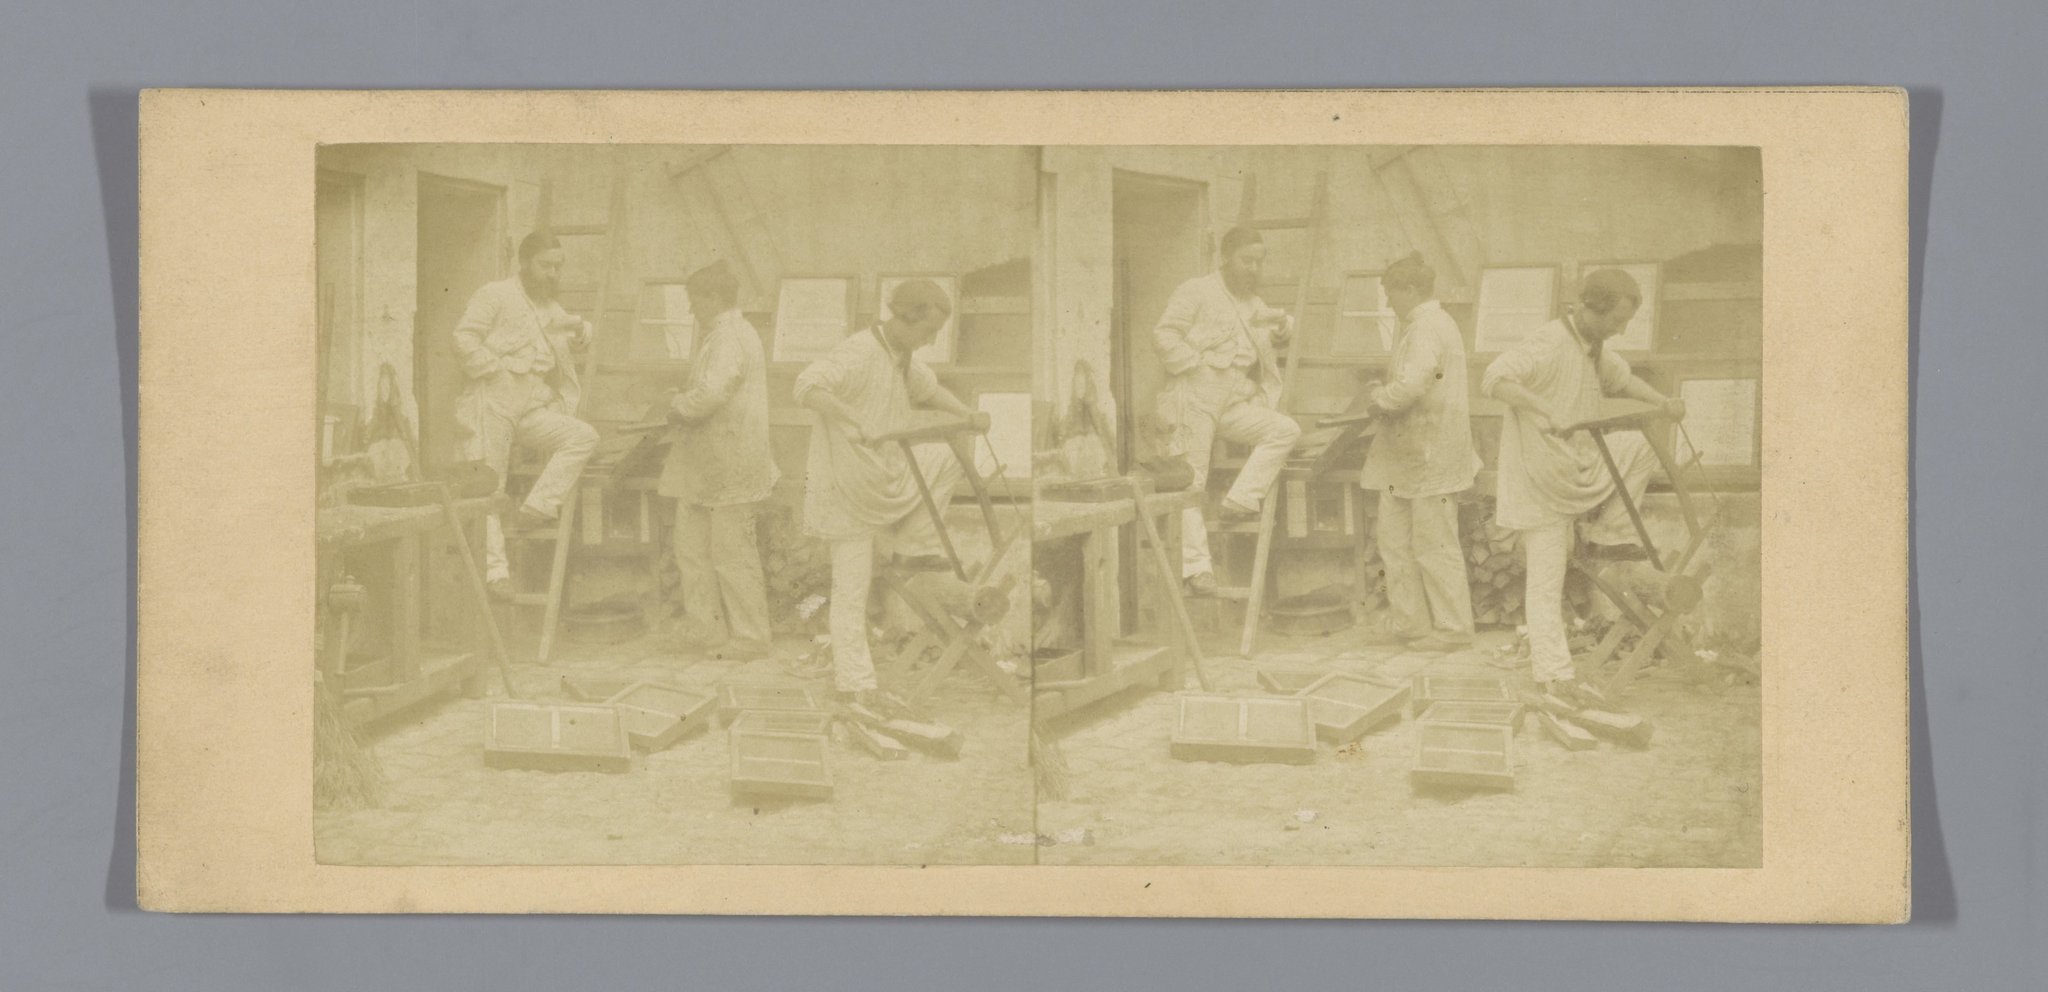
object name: stereograph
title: Drie timmerlieden in een werkplaats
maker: Anonymous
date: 1850-1880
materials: cardboard, photographic support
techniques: albumen print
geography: europe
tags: carpenter, europe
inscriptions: number: ‘No. 53. xxx’